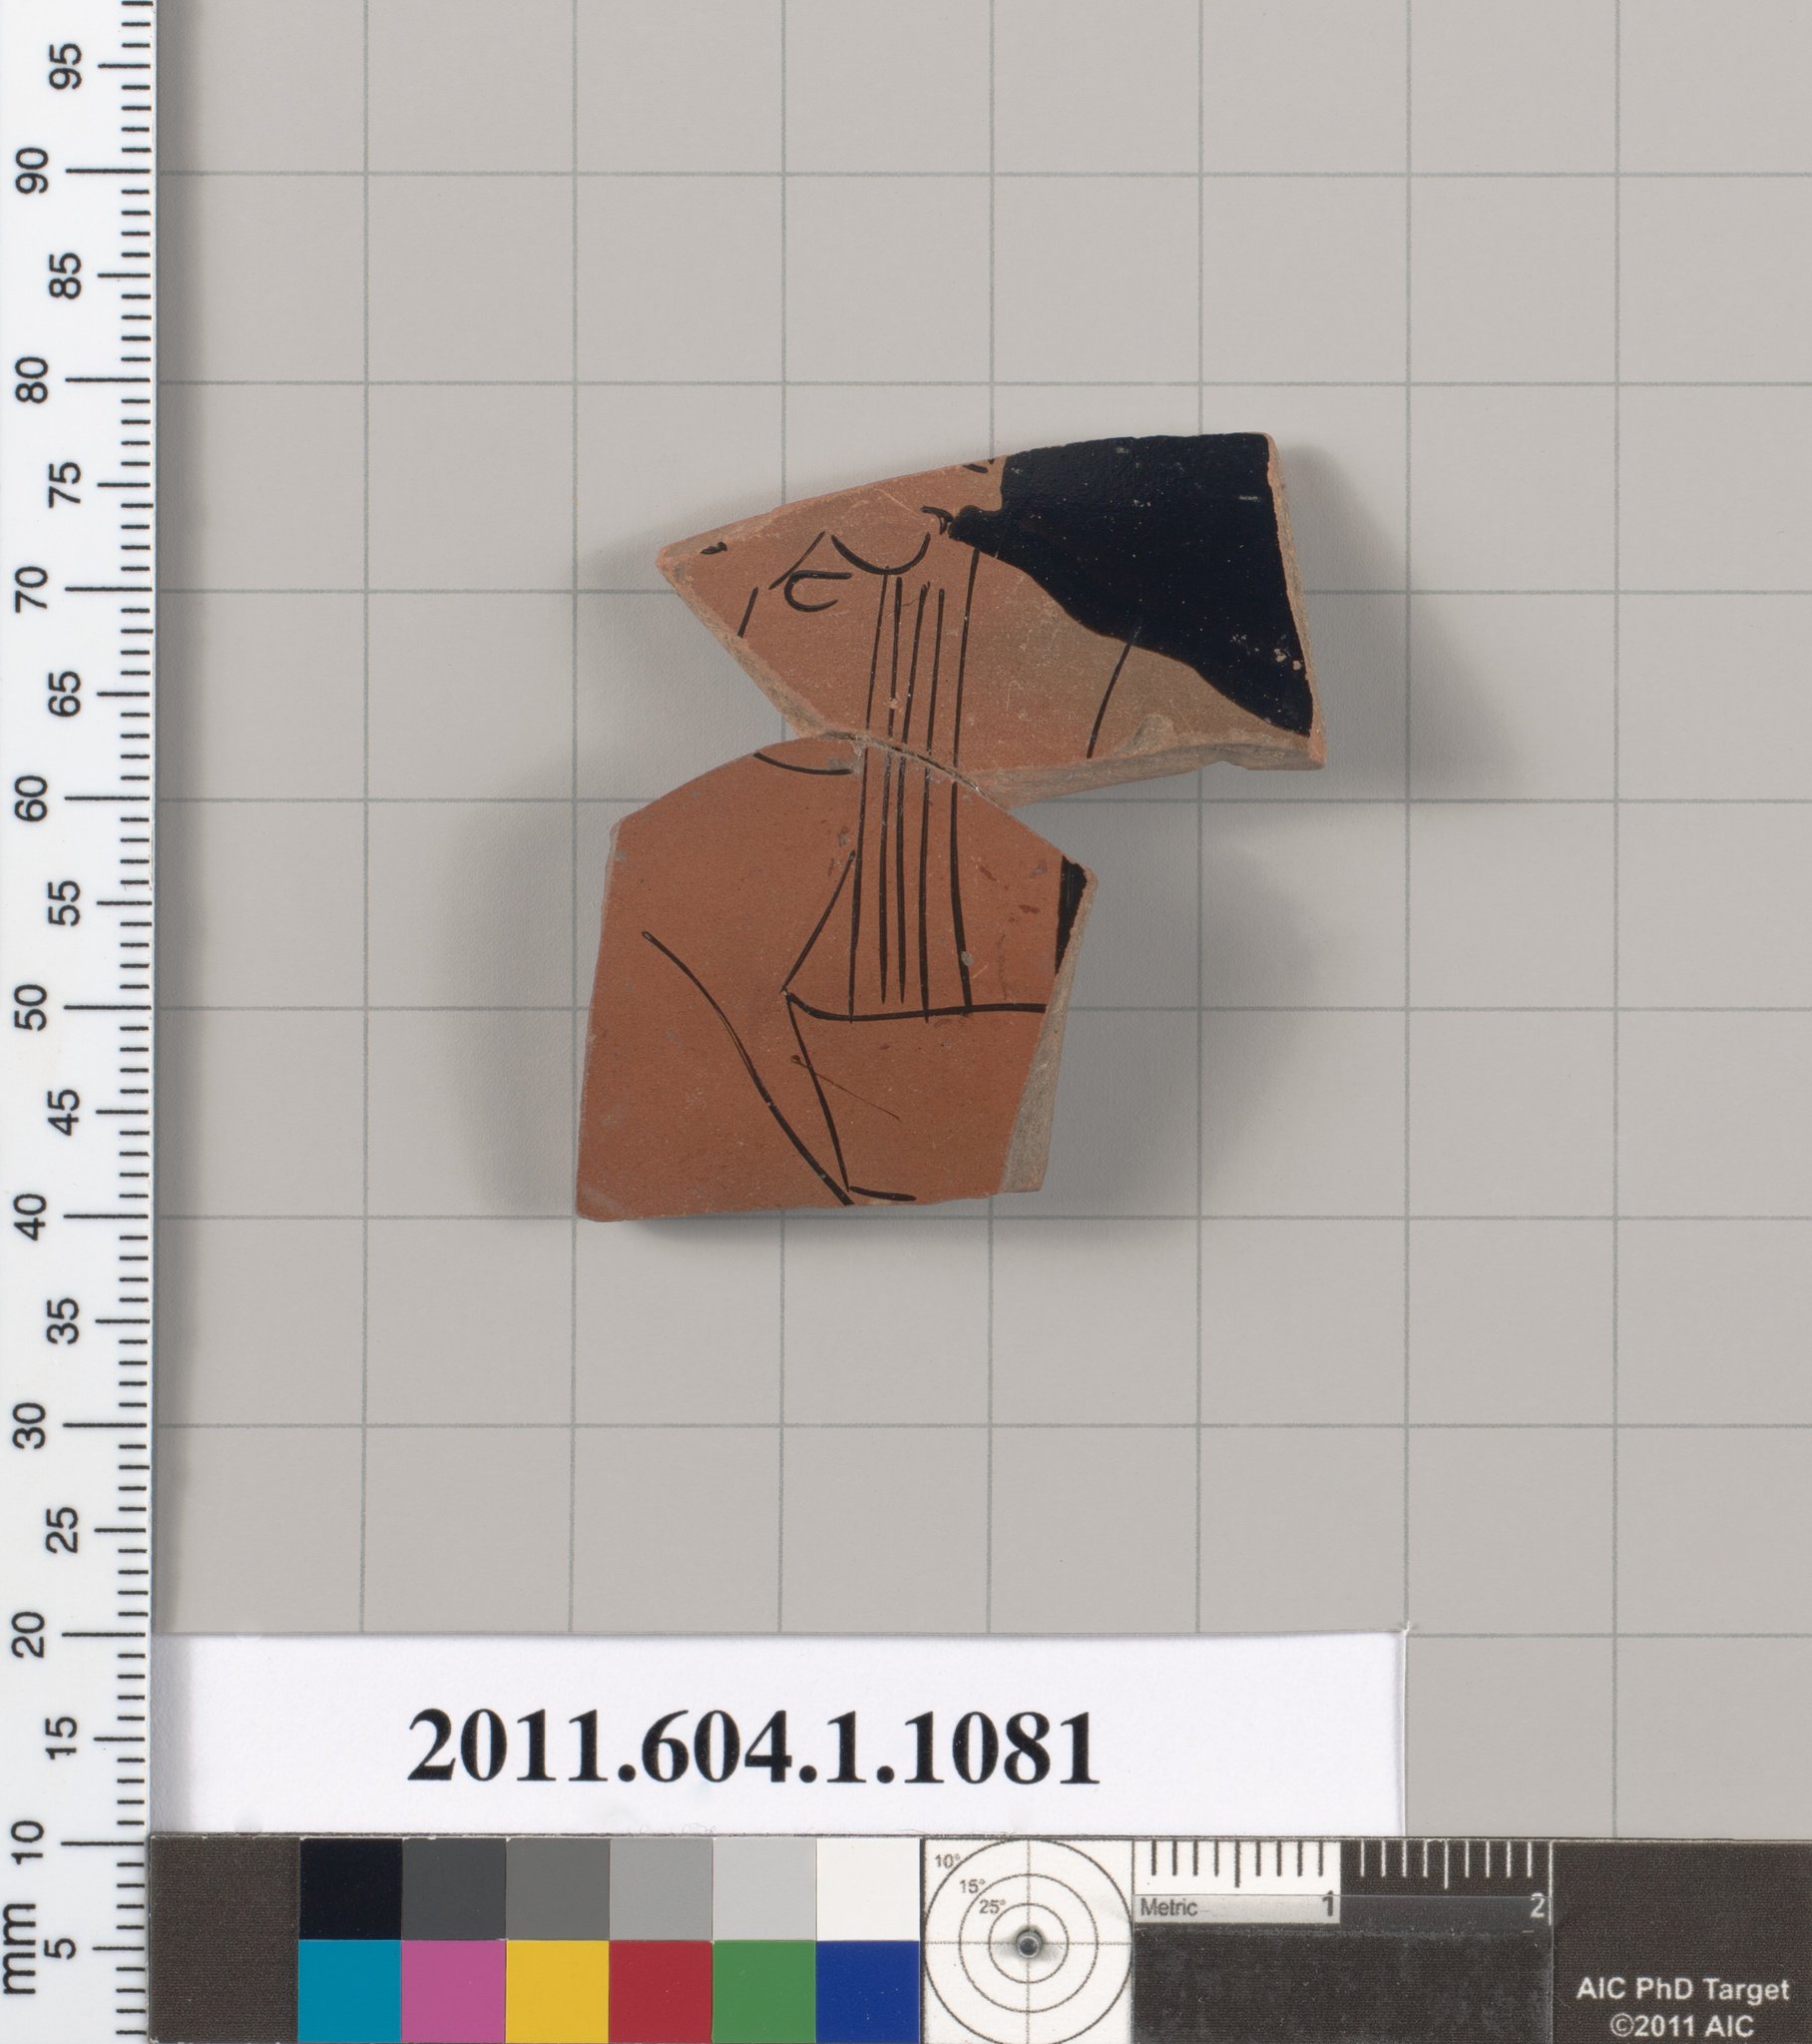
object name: kylix fragment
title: Terracotta fragment of a kylix (drinking cup)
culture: greek, attic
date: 475-451 BCE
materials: terracotta